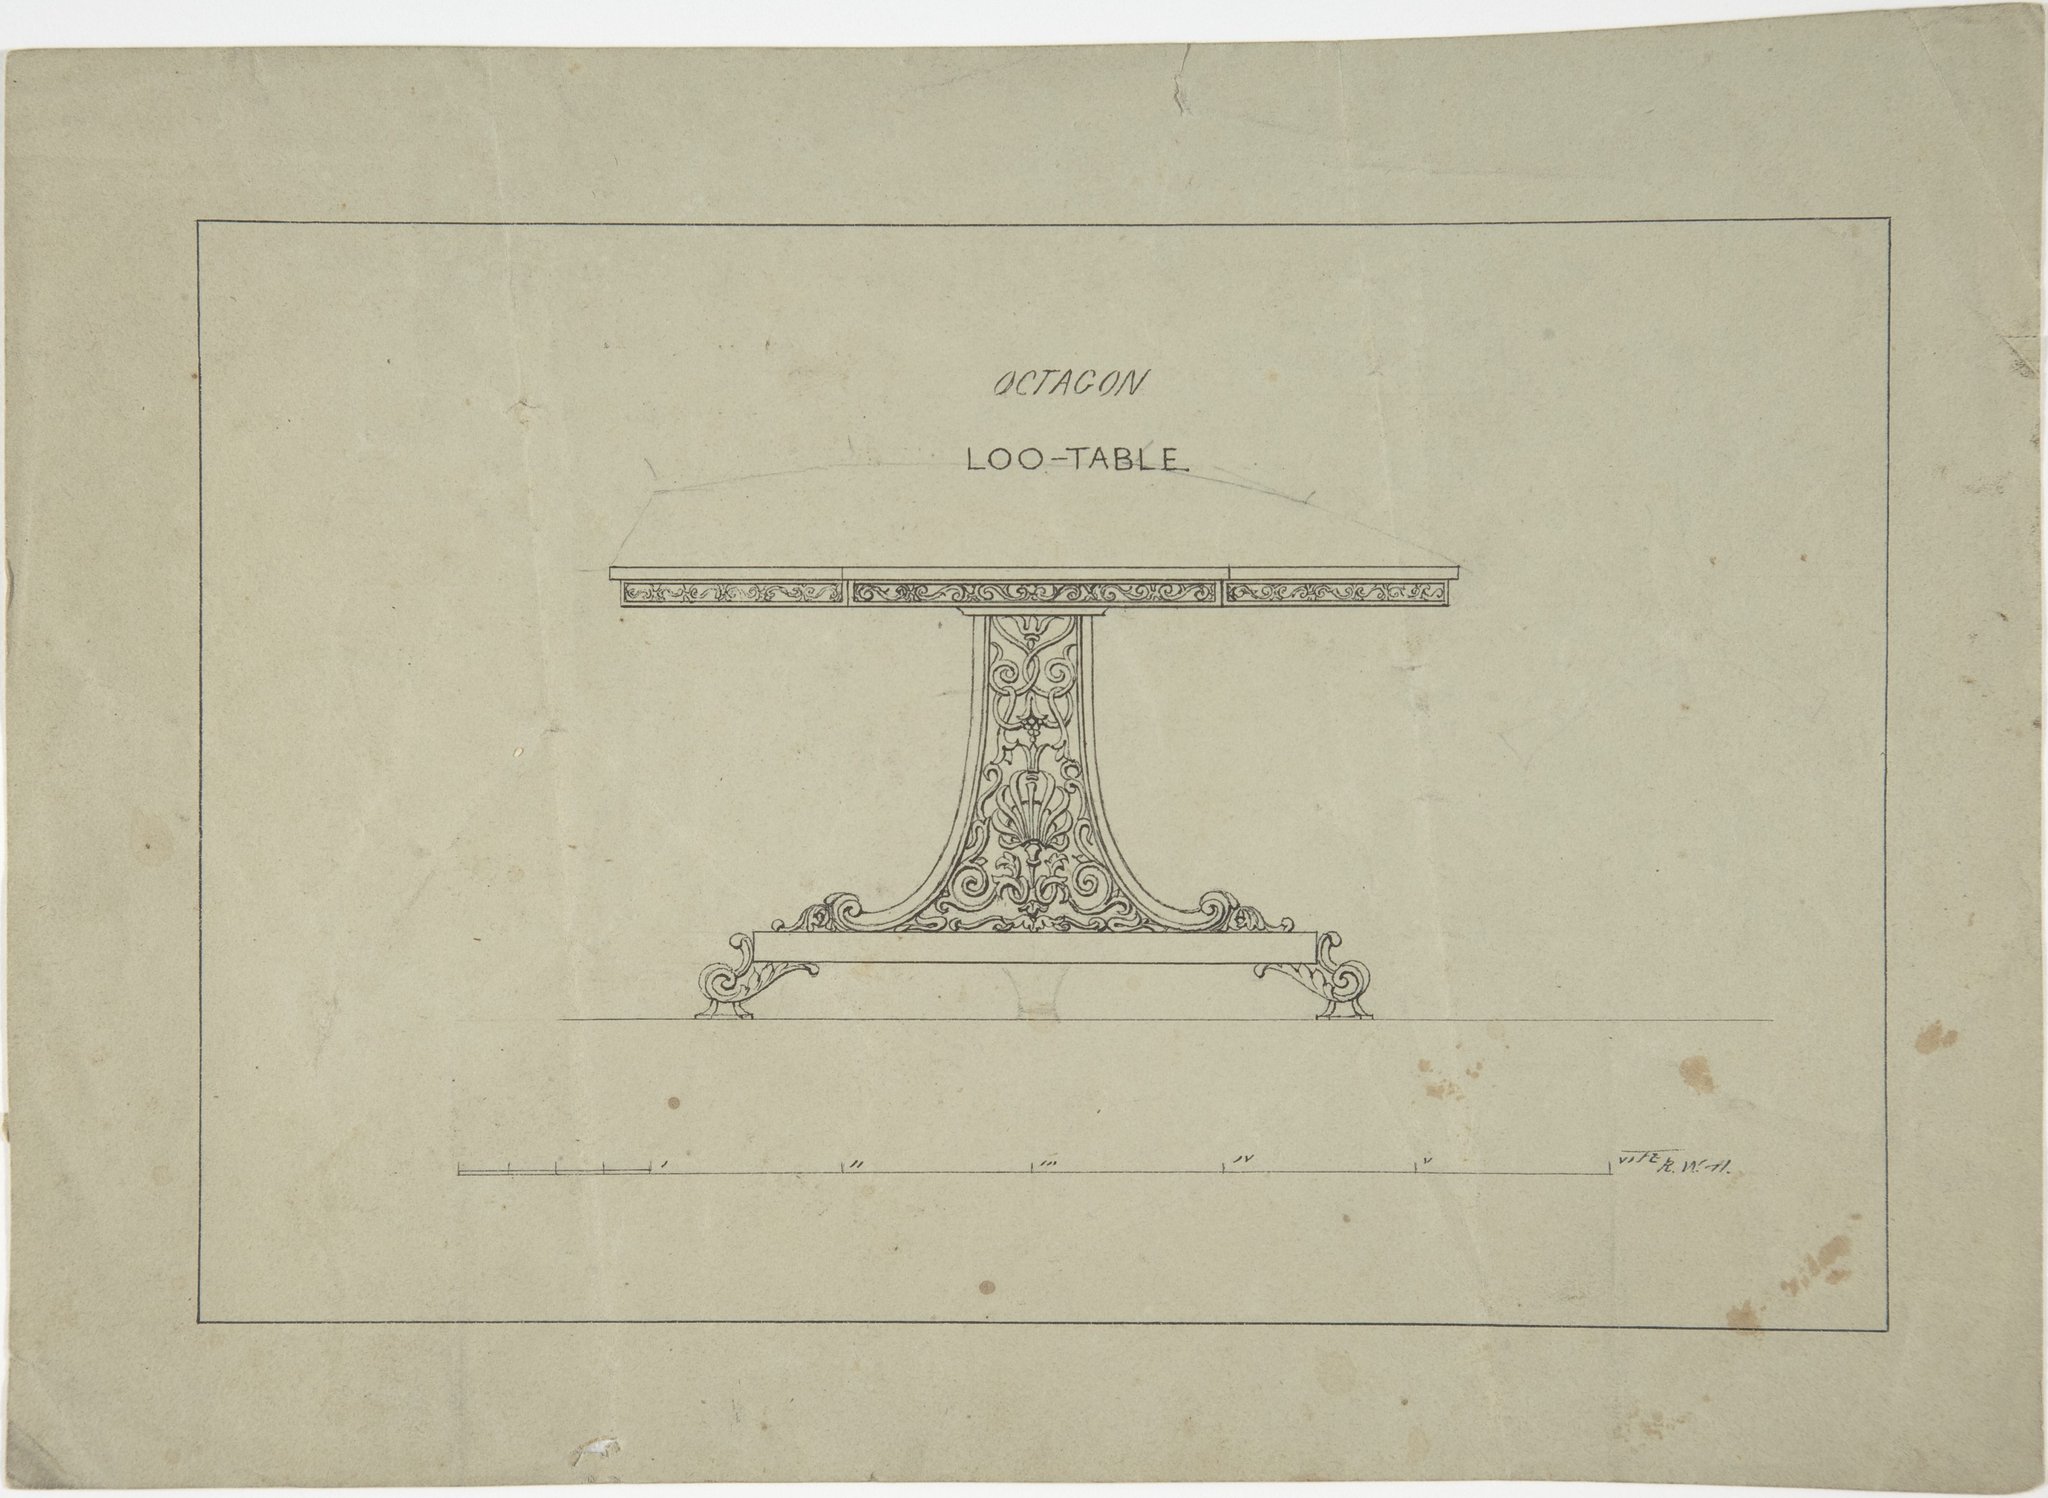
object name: drawing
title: Design for Loo-Table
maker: robert william hume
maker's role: artist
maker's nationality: british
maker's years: 1816-1904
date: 1835-1900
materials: ink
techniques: pen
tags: tables